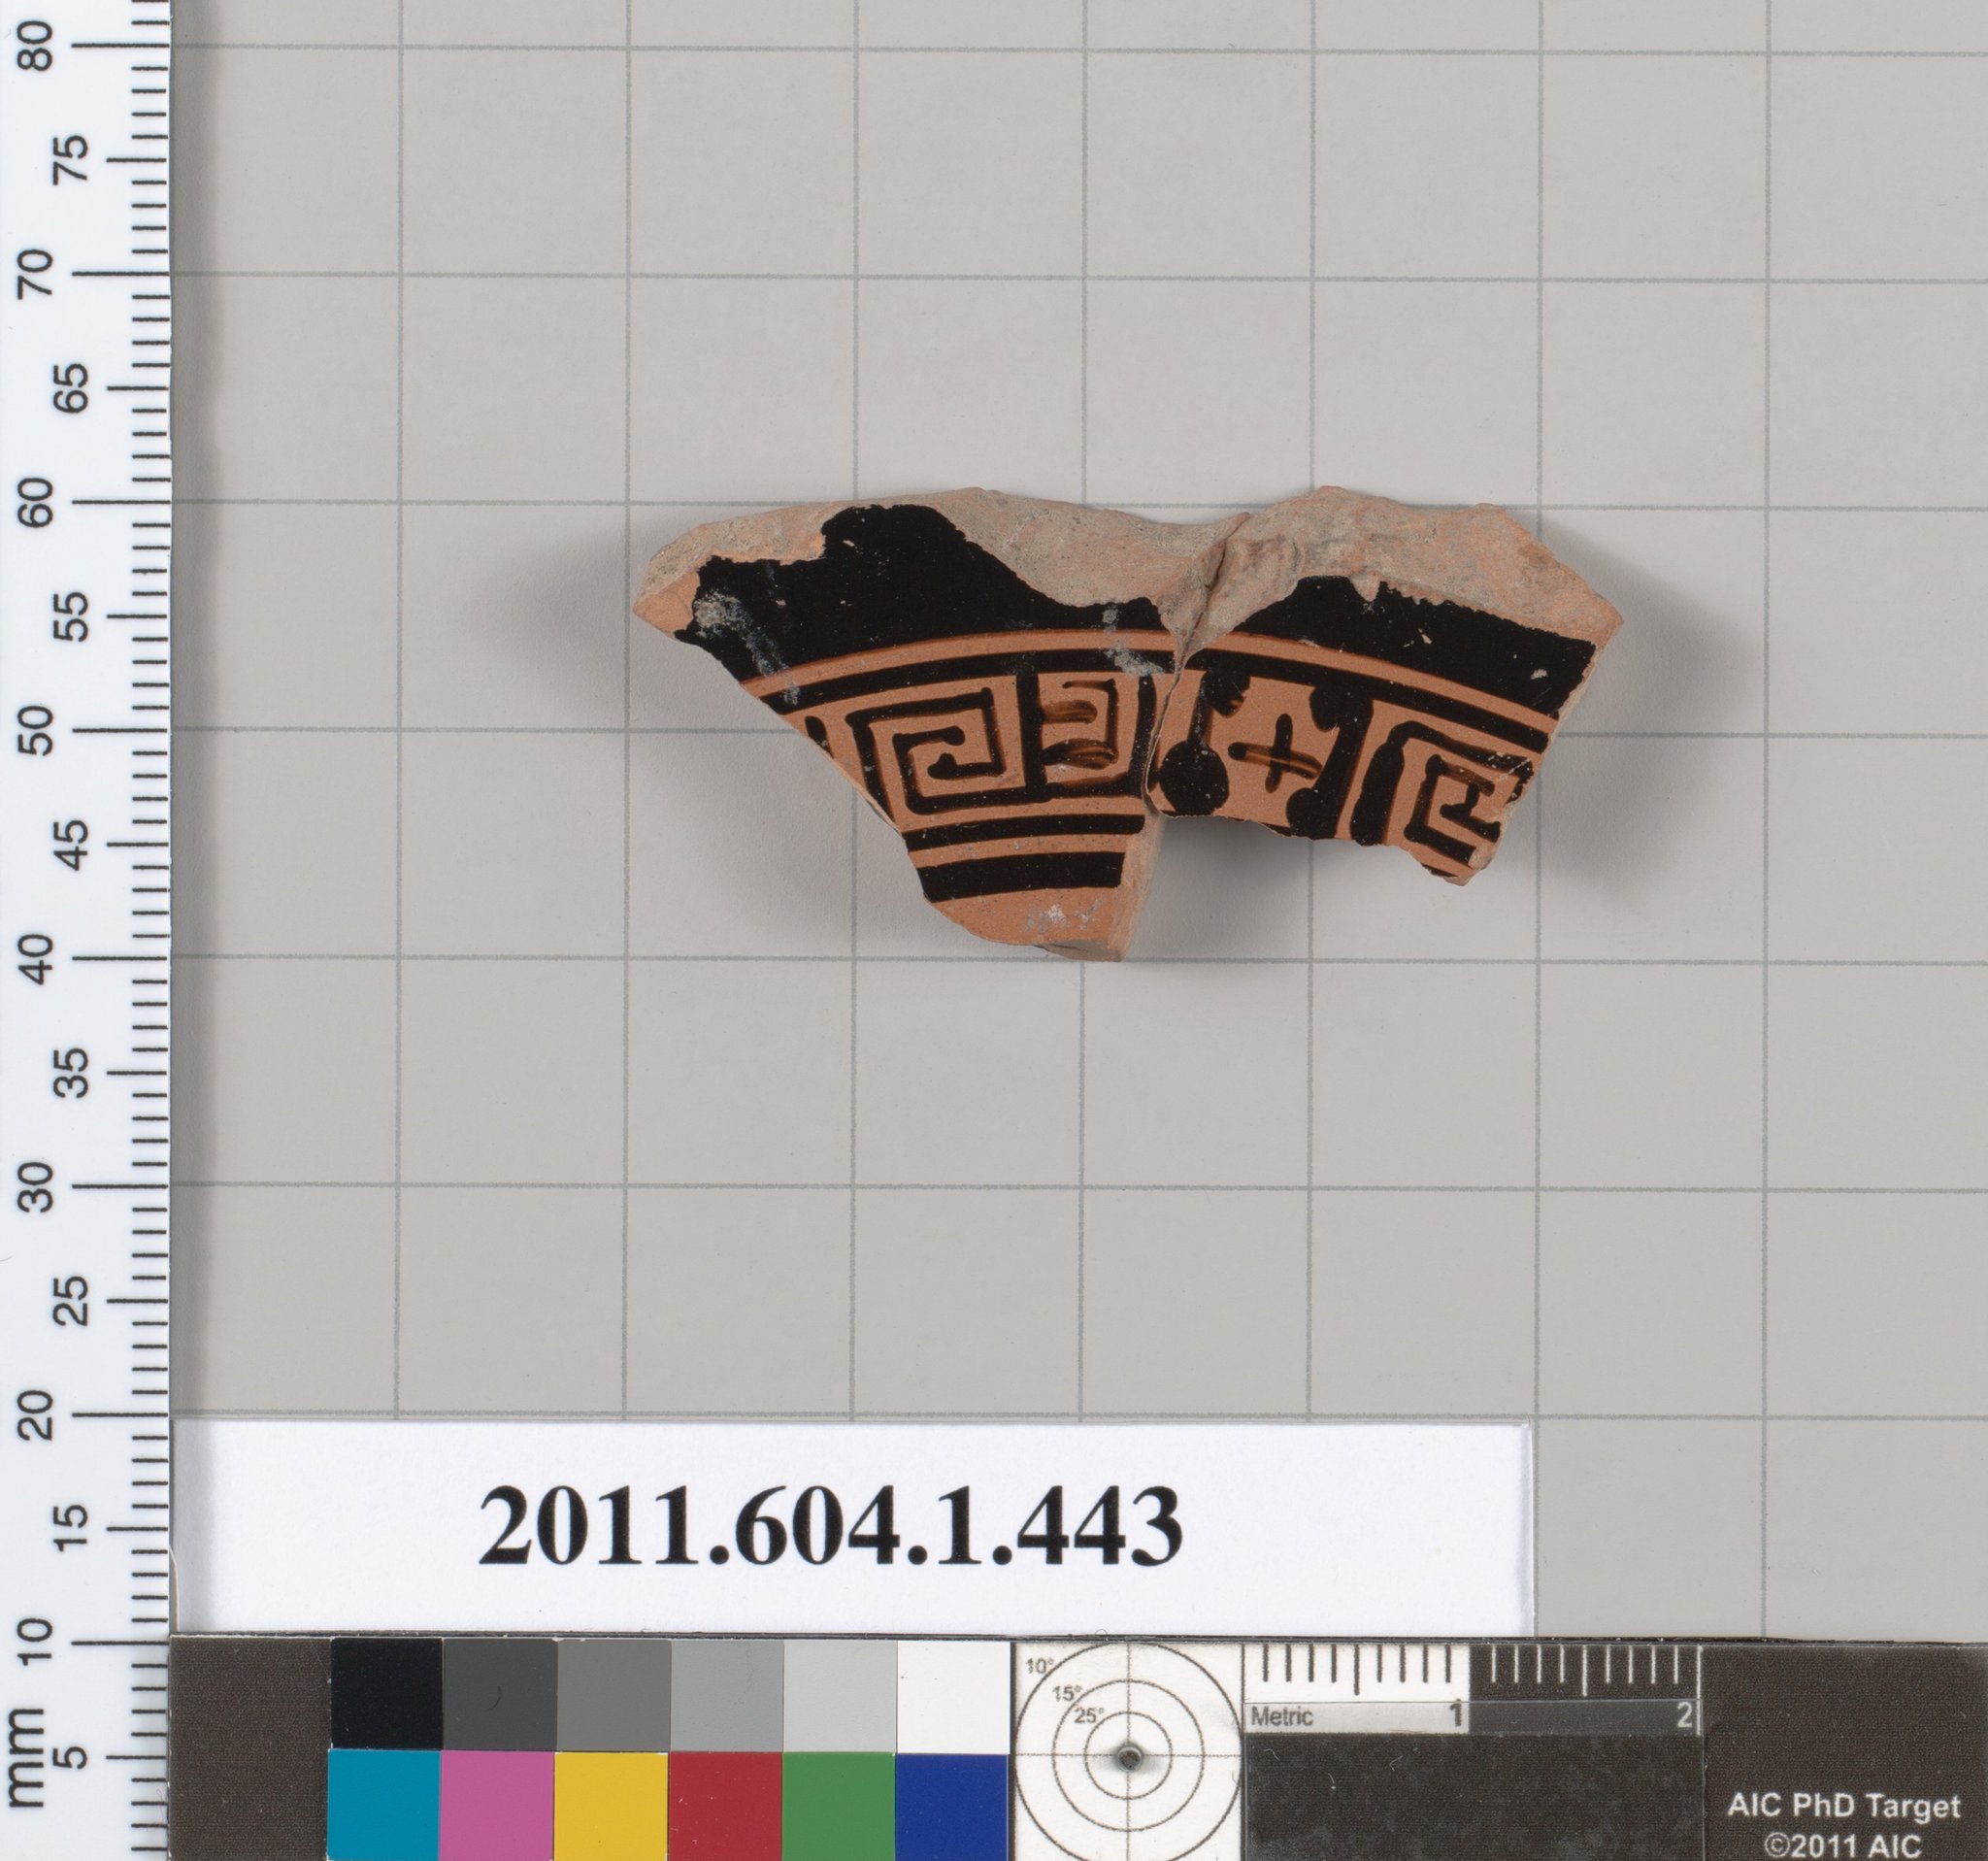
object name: kylix fragment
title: Terracotta fragment of a kylix (drinking cup)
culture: greek, attic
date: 475-451 BCE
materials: terracotta